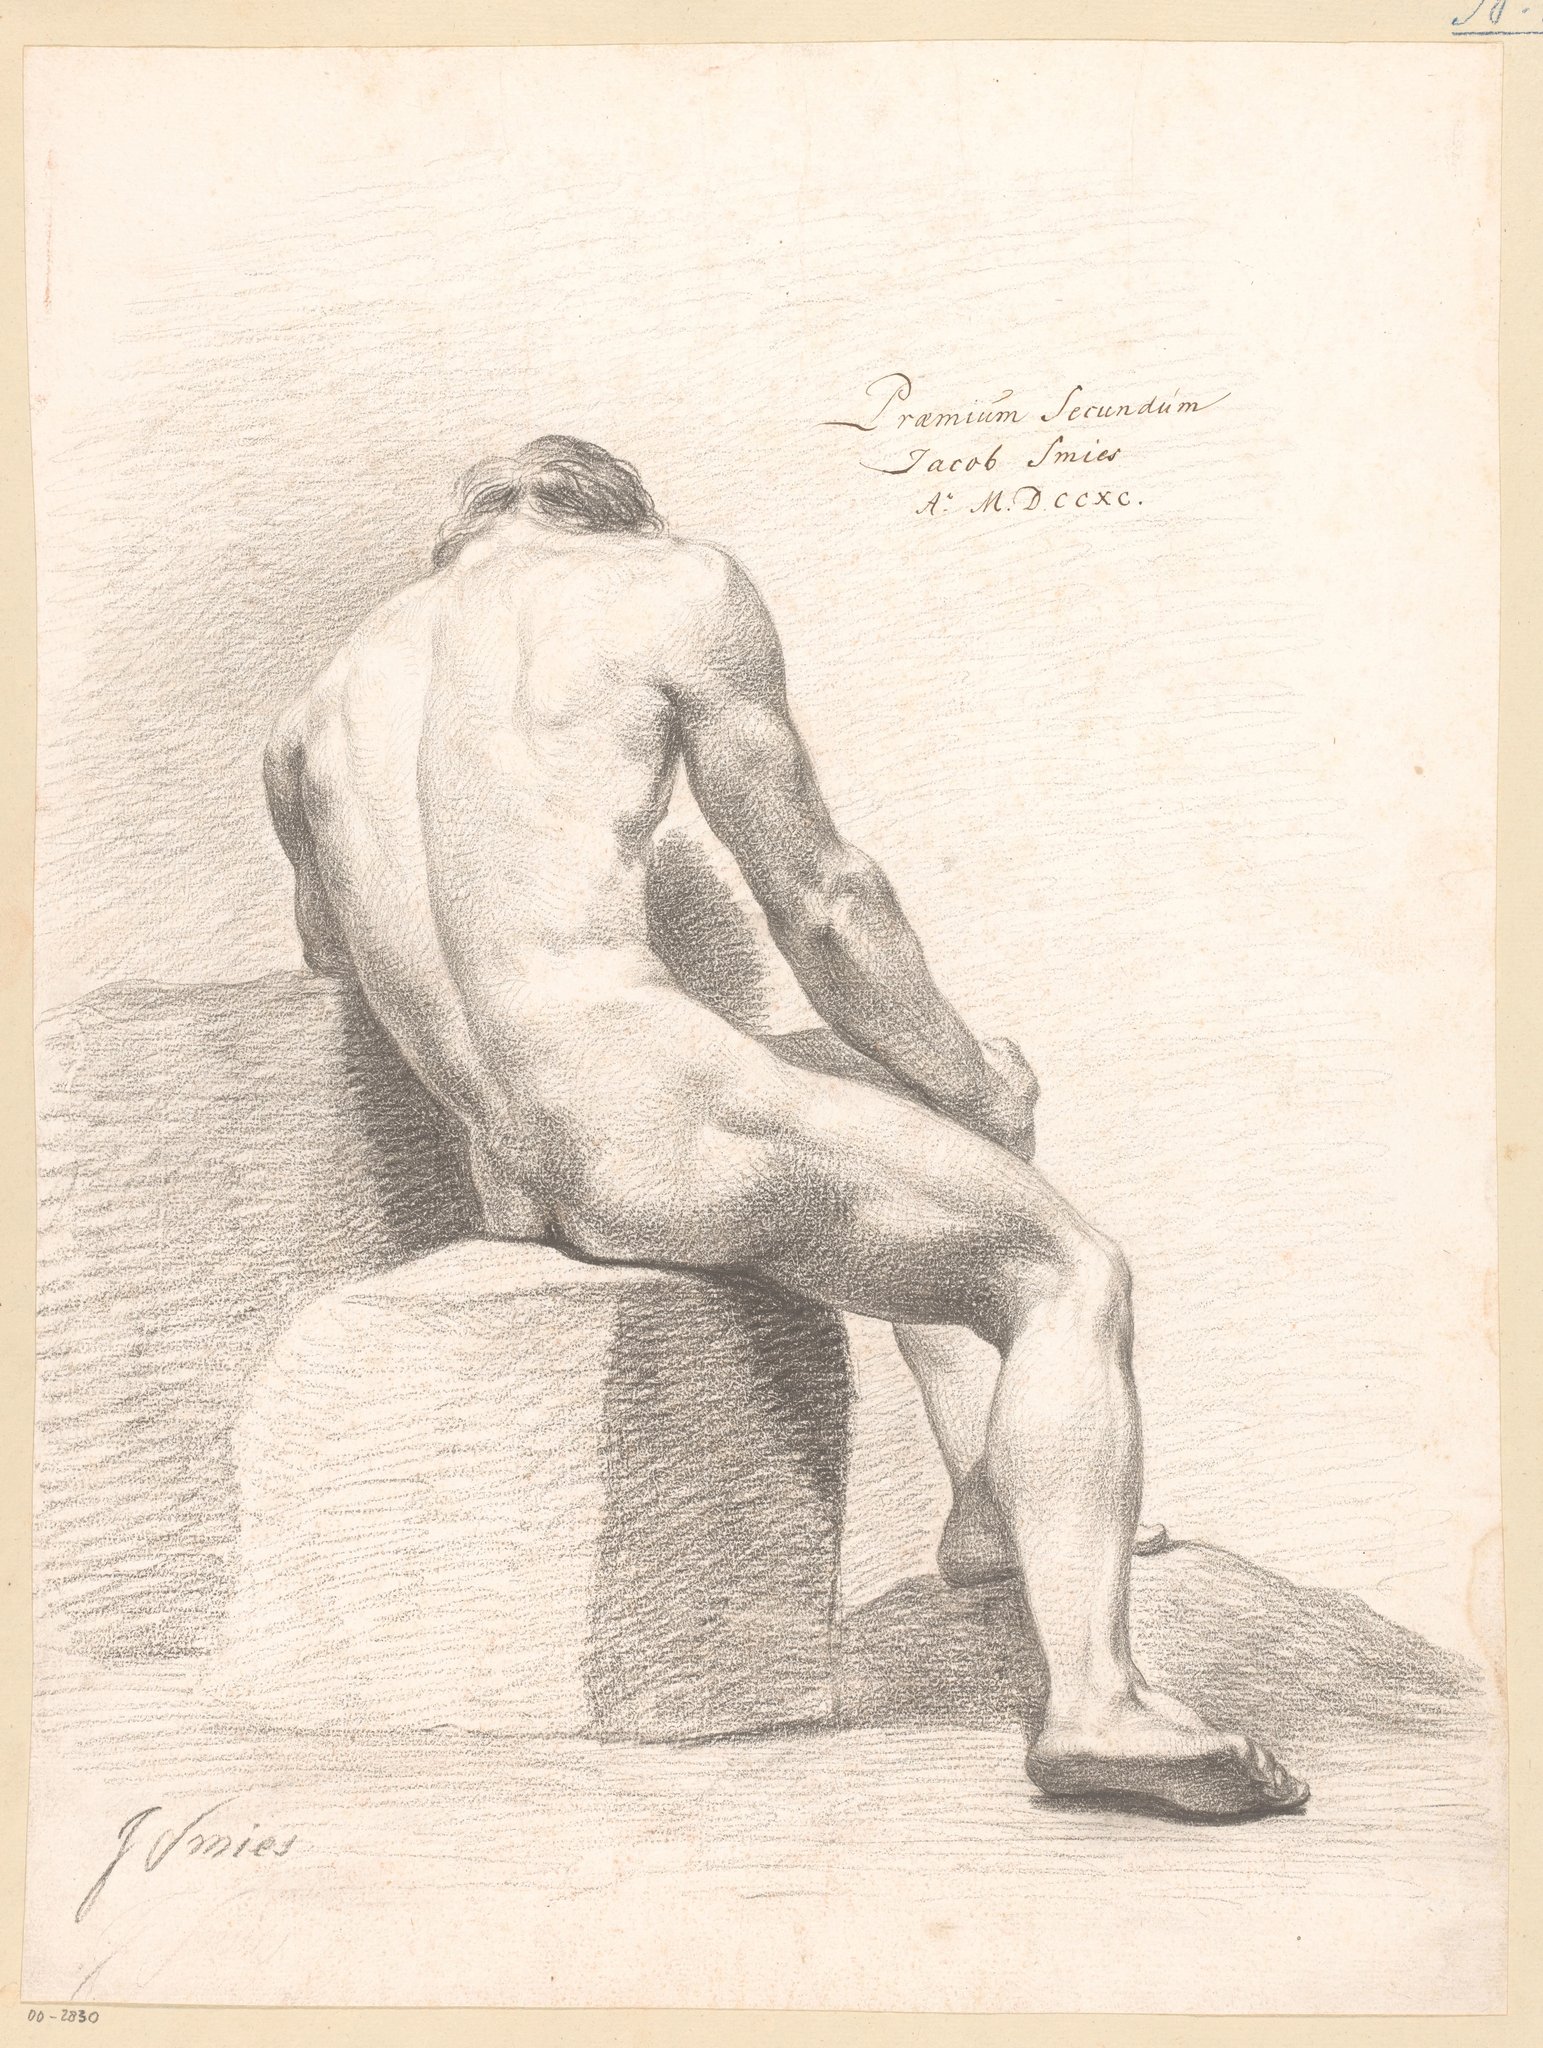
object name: drawing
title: Zittend mannelijk naakt, op de rug gezien (2e prijs 1790)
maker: jacob smies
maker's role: draughtsman, painter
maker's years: 1746-1833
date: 1790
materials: chalk, paper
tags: sitting figure (+ nude human being)